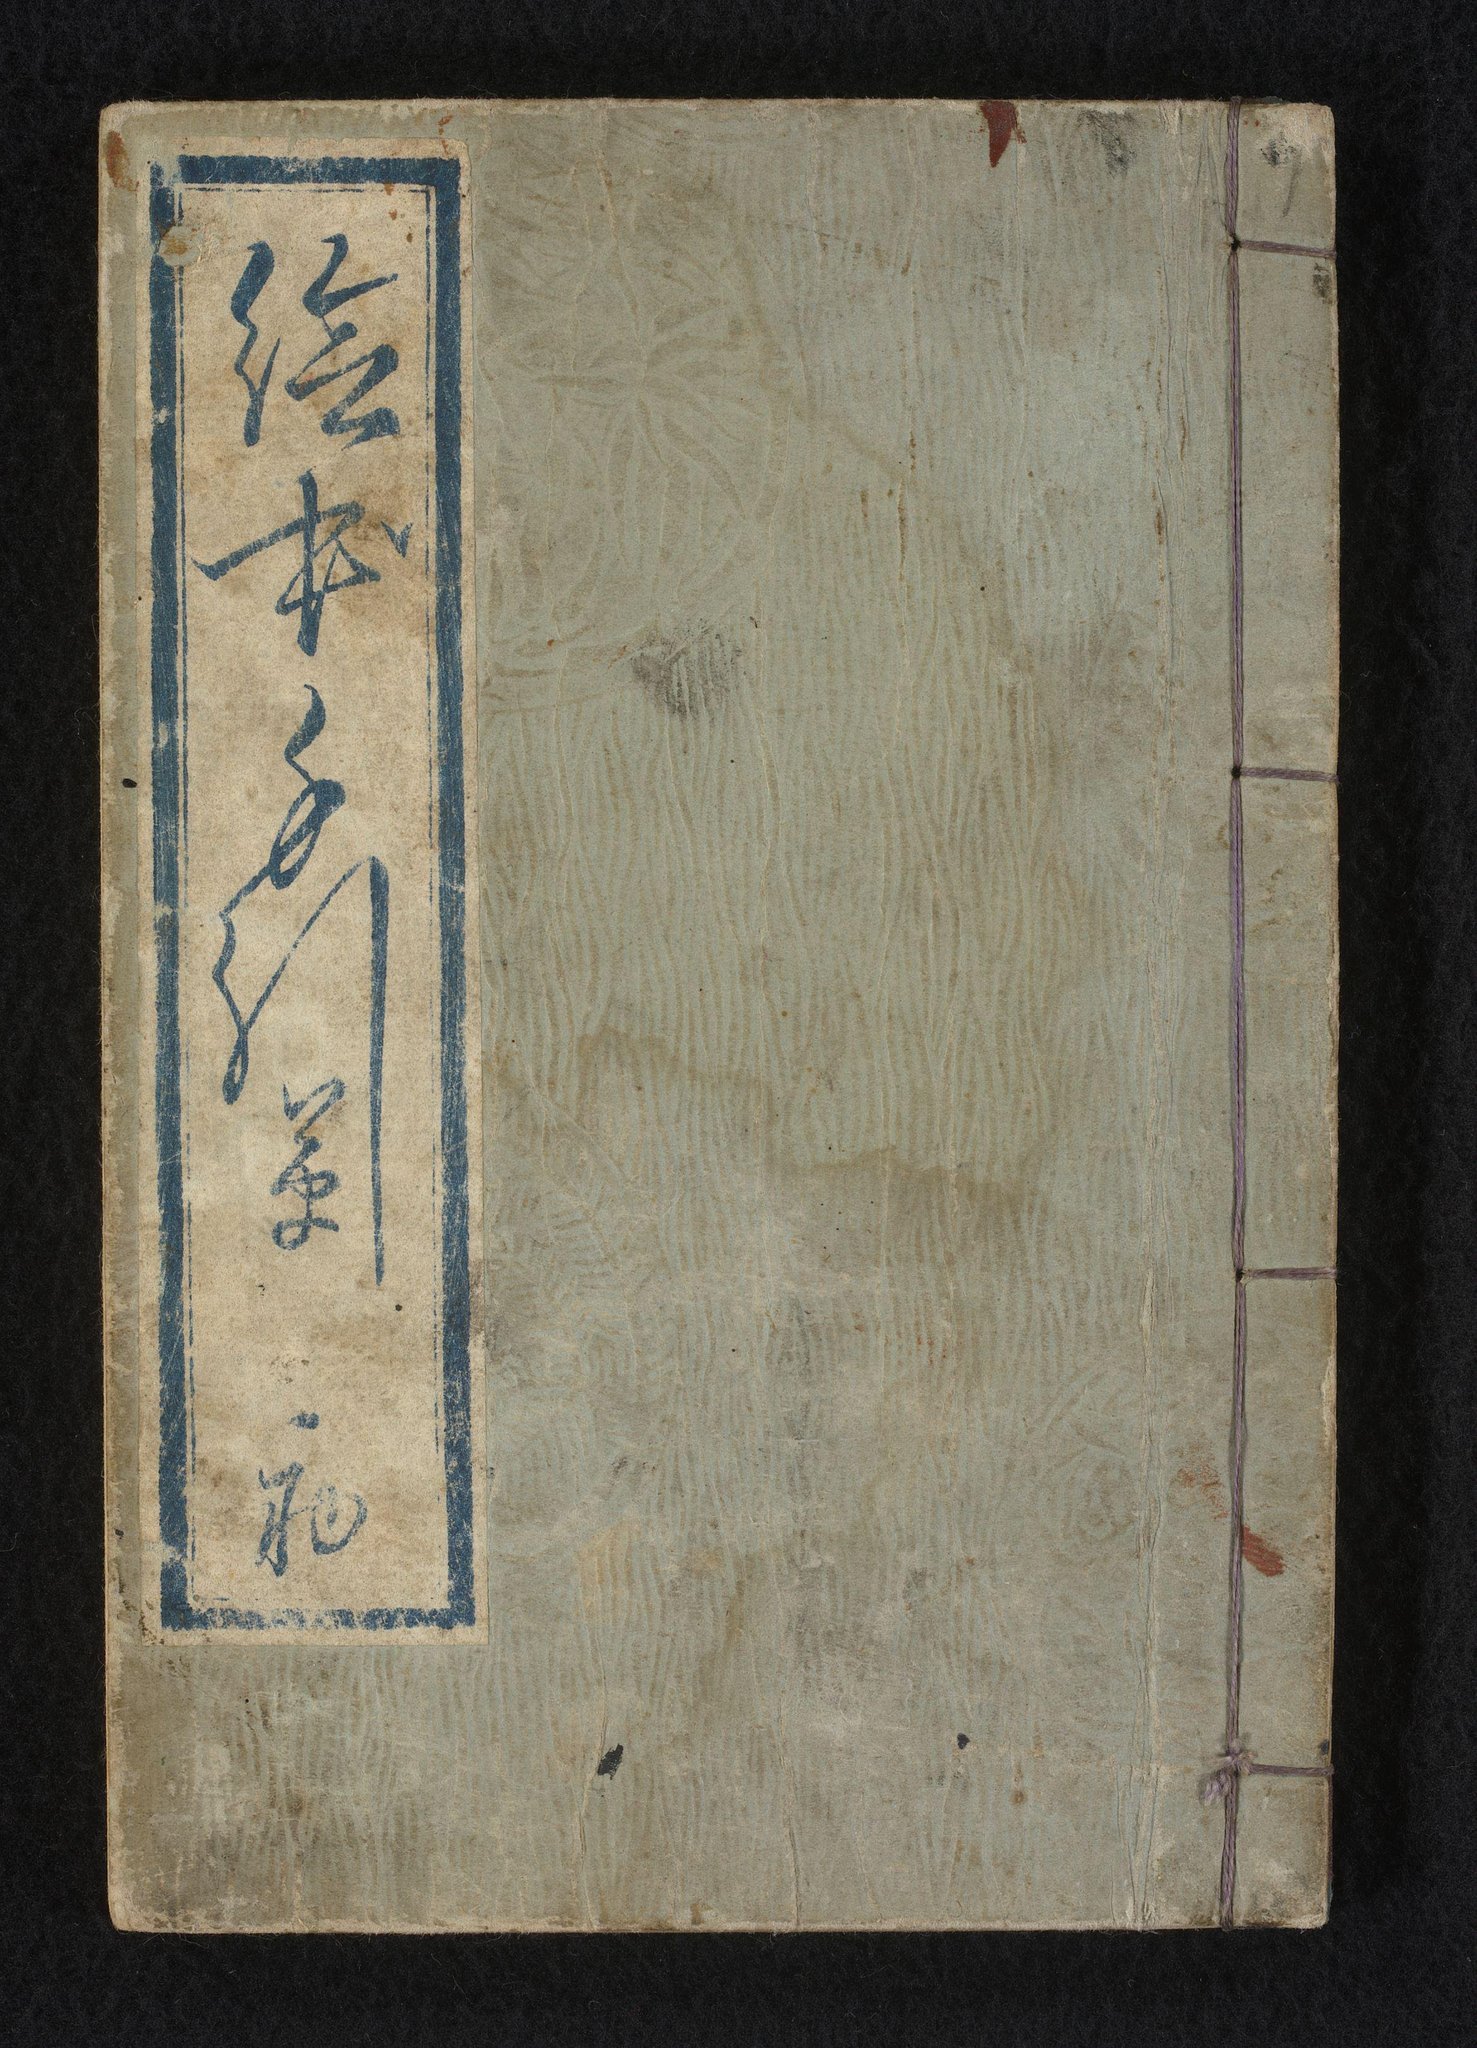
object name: book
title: Een geïllustreerde handleiding voor planten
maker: utagawa hiroshige (i)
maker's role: draughtsman, print maker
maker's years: 1797-1858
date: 1849-1854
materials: paper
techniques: blind stamped, woodcut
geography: japan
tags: flowers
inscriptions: collector's mark: Lugt 2228